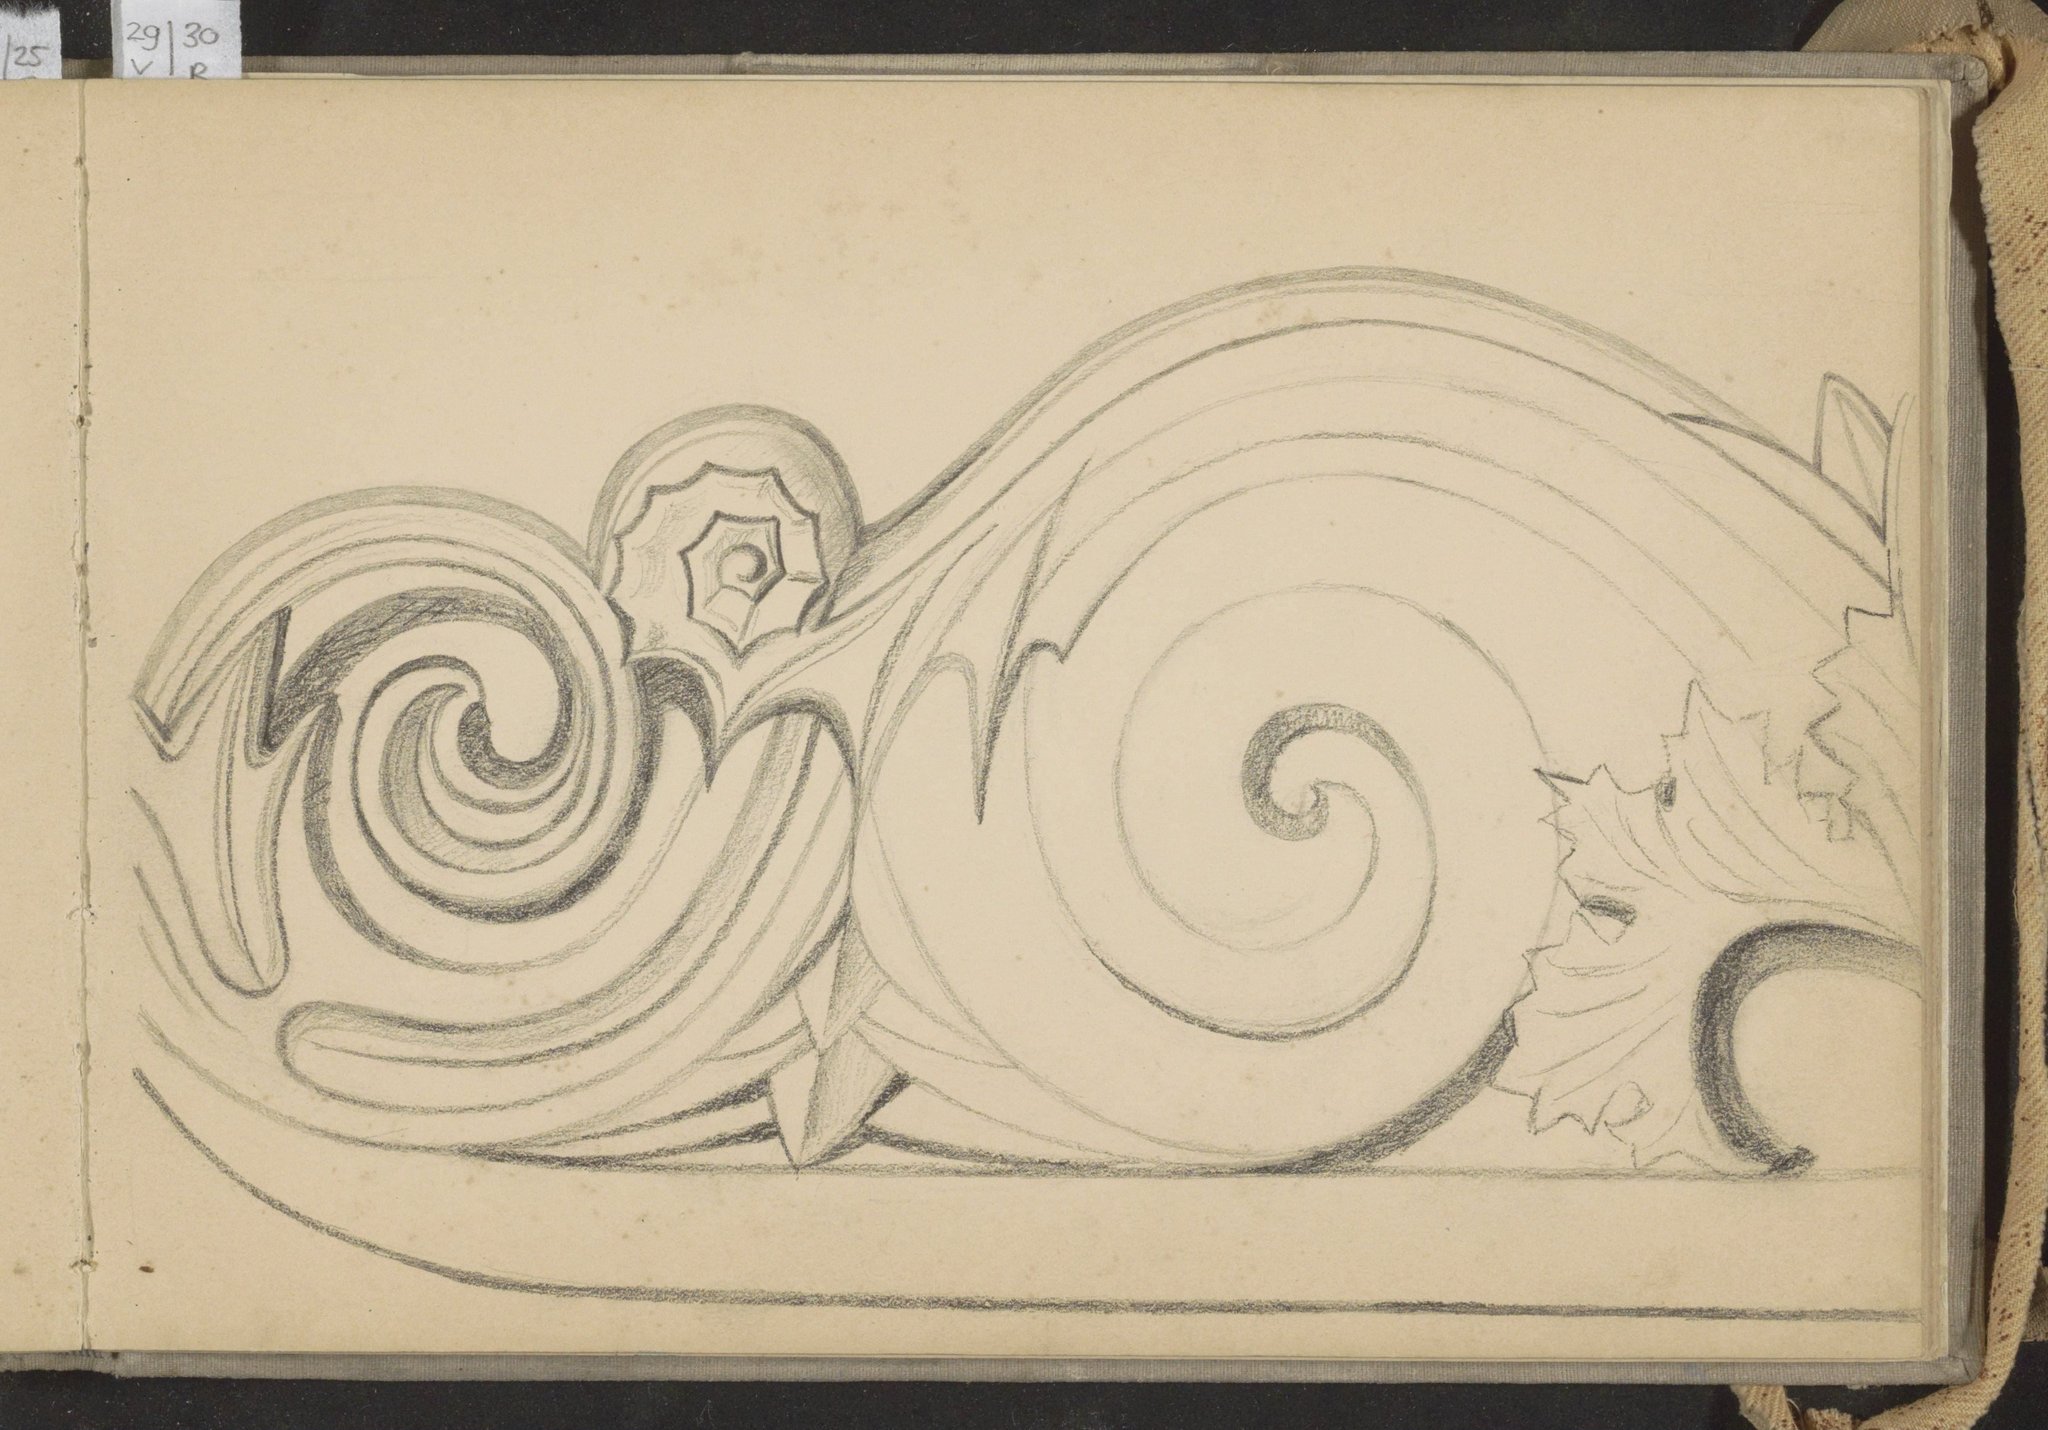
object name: sketchbook leaf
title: Lijstwerk met acanthusbladeren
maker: johanna van de kamer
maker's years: 1873-1922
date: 1890-1922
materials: paper, pencil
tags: other architectural details (cornice), acanthus ~ ornament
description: Blad 27 recto uit een schetsboek met 43 bladen.